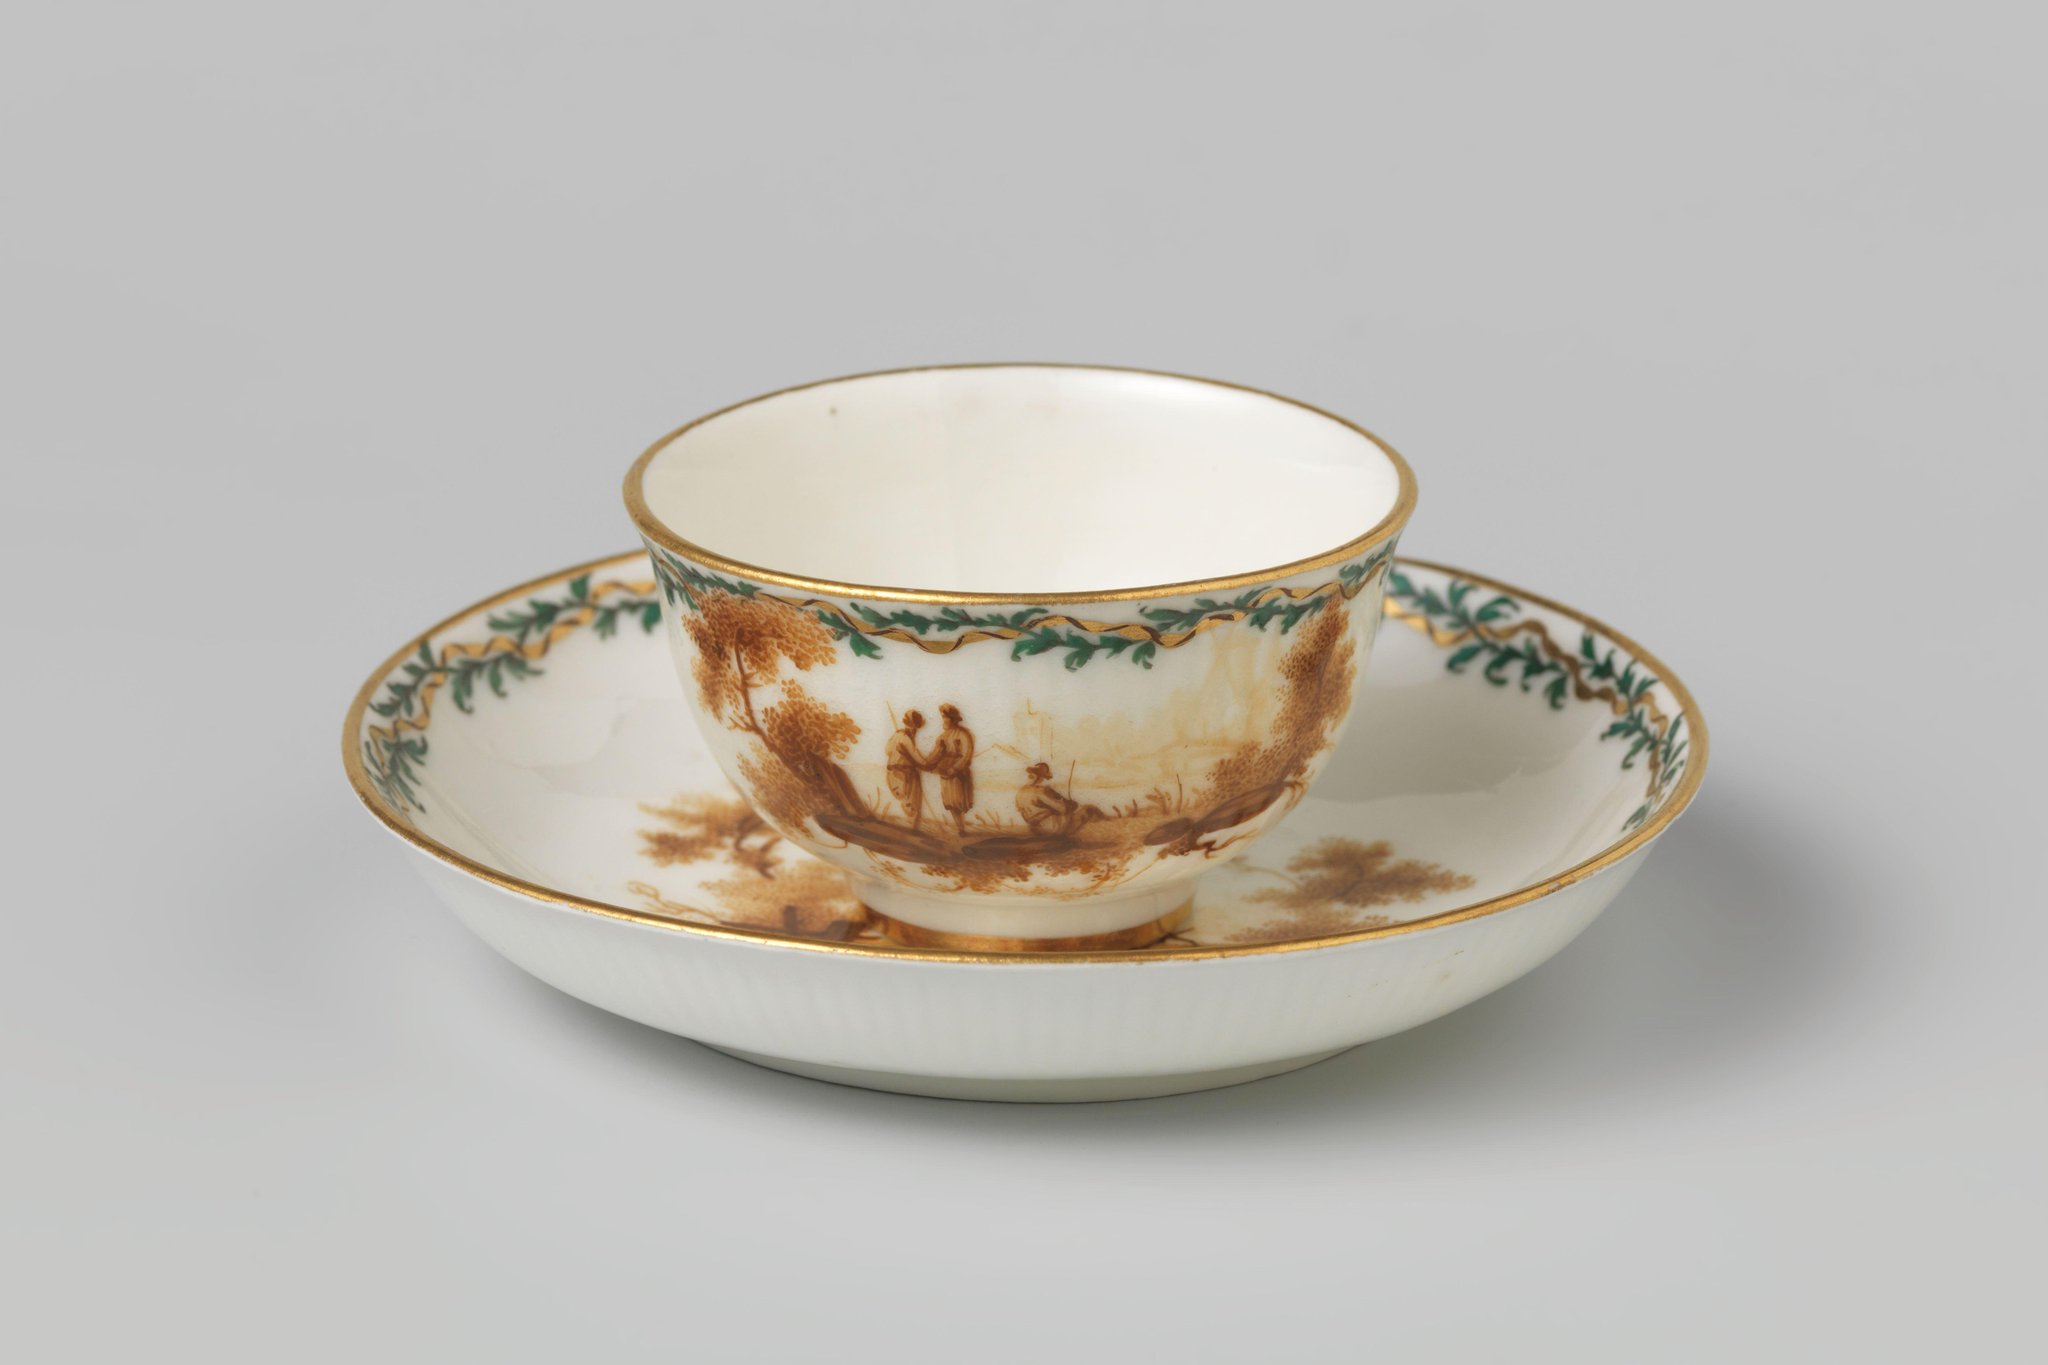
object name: cup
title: Kop, beschilderd met figuren in een landschap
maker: fidelle duvivier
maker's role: porseleinschilder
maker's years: 1740-1817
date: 1778-1782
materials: porcelain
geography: loosdrecht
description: Kop van porselein. Kop zonder oor. Beschilderd in sepia met figuren in een landschap. Op de achterkant van de kop een grondje. Langs de randen een kronkelend lint in goud en bruin, waaromheen zich een groene bladtak slingert. De buitenwand van de kop is versierd met twee rijen verspringende ribben. Gouden biezen langs voet- en mondrand van de kop.